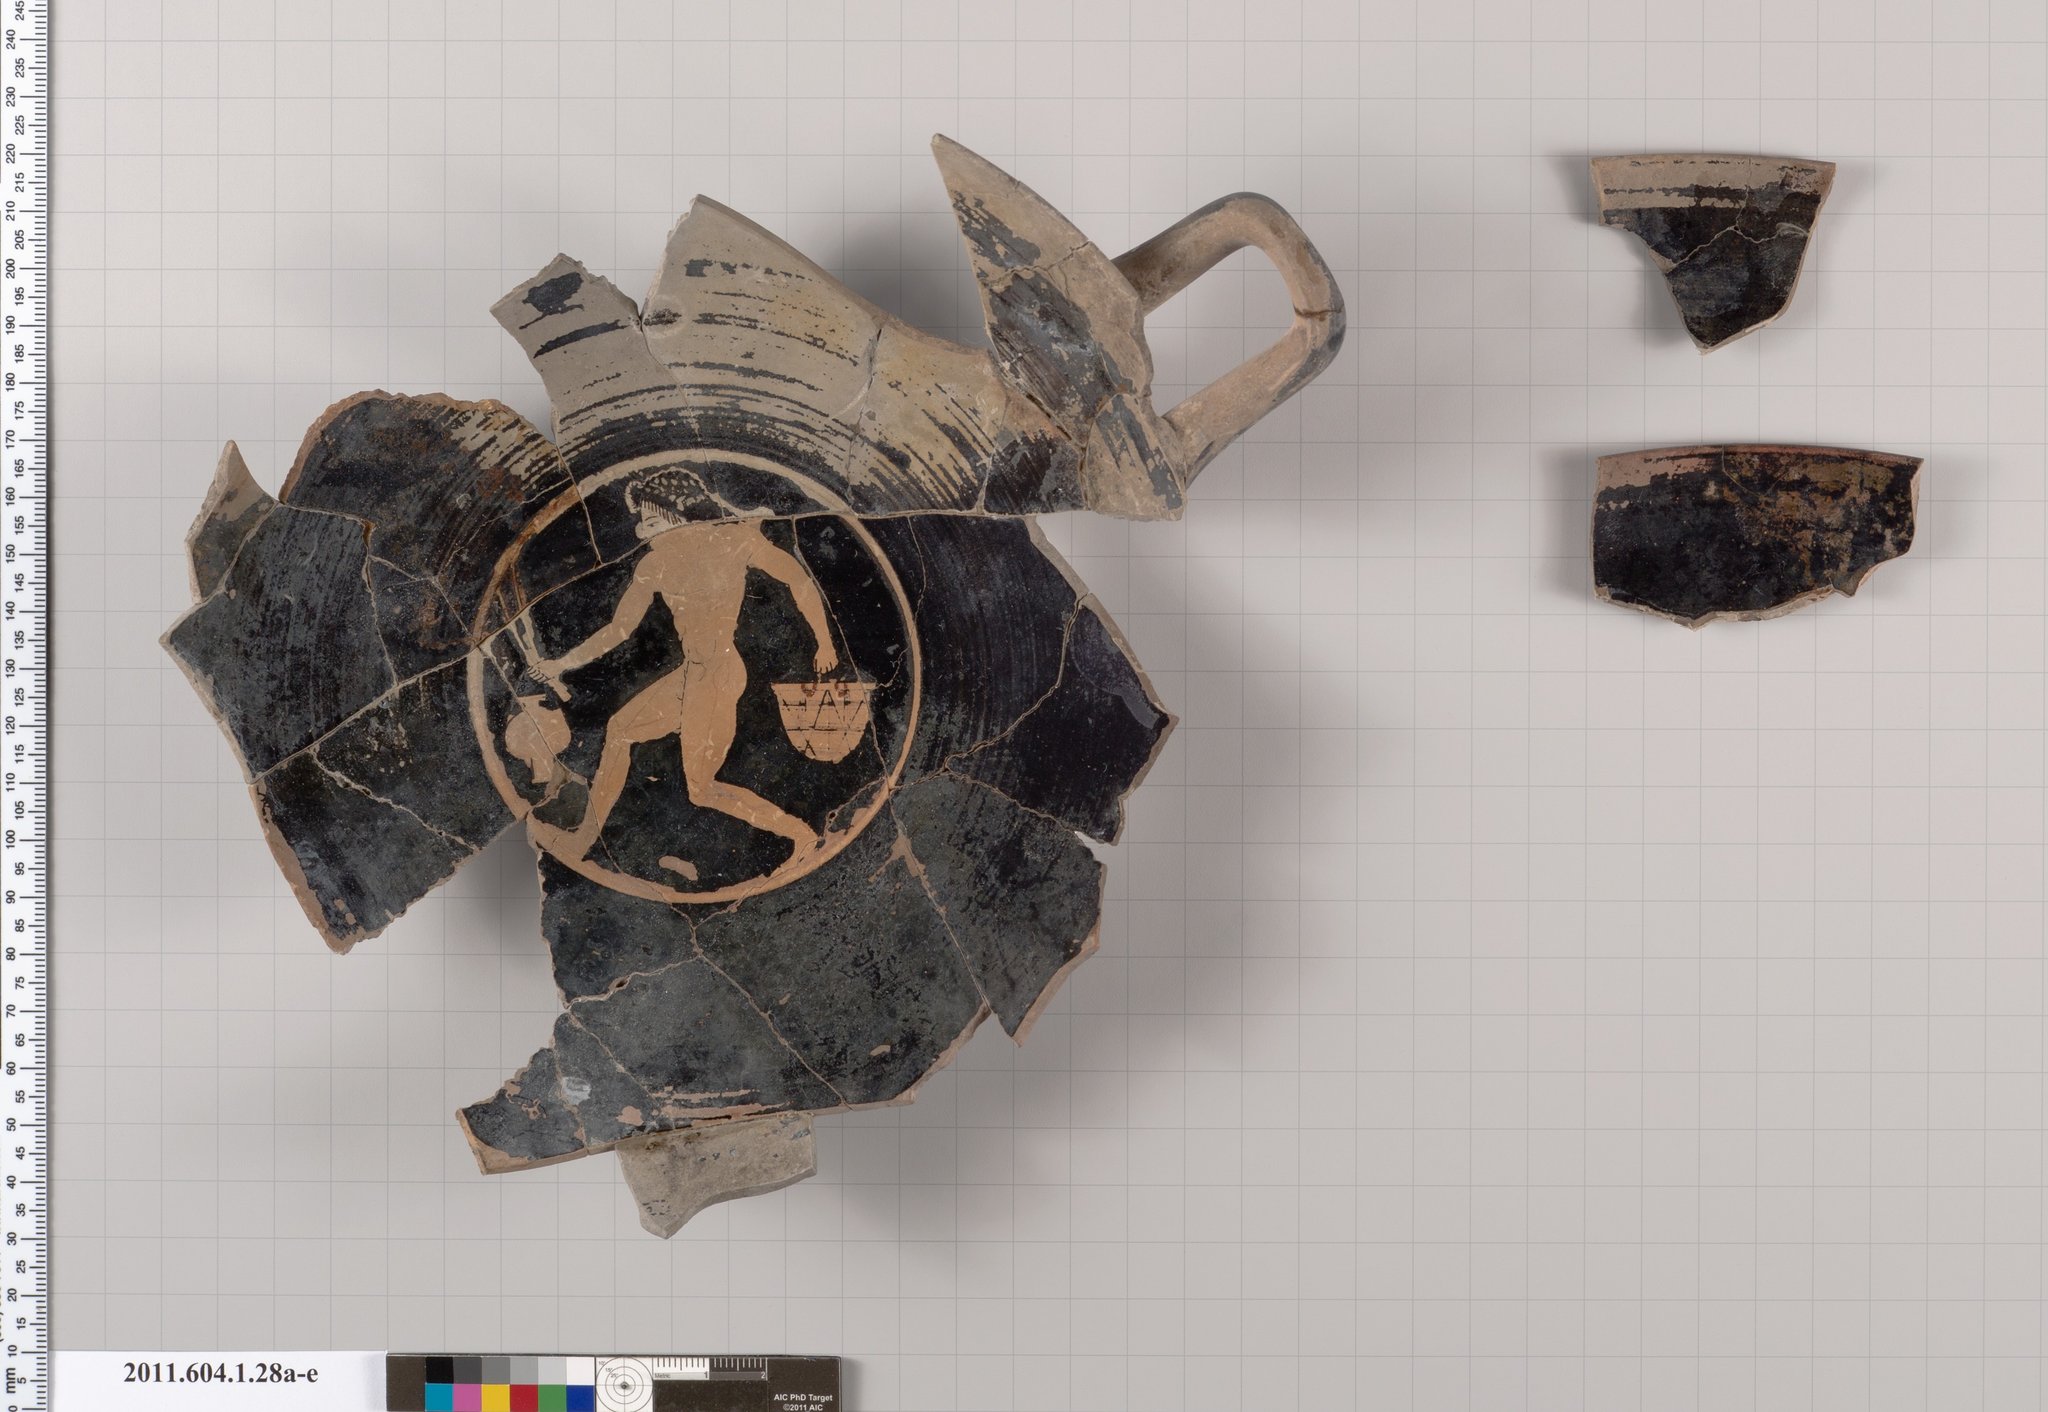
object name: kylix fragment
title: Terracotta fragments of a kylix (drinking cup)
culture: greek, attic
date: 534-501 BCE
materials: terracotta